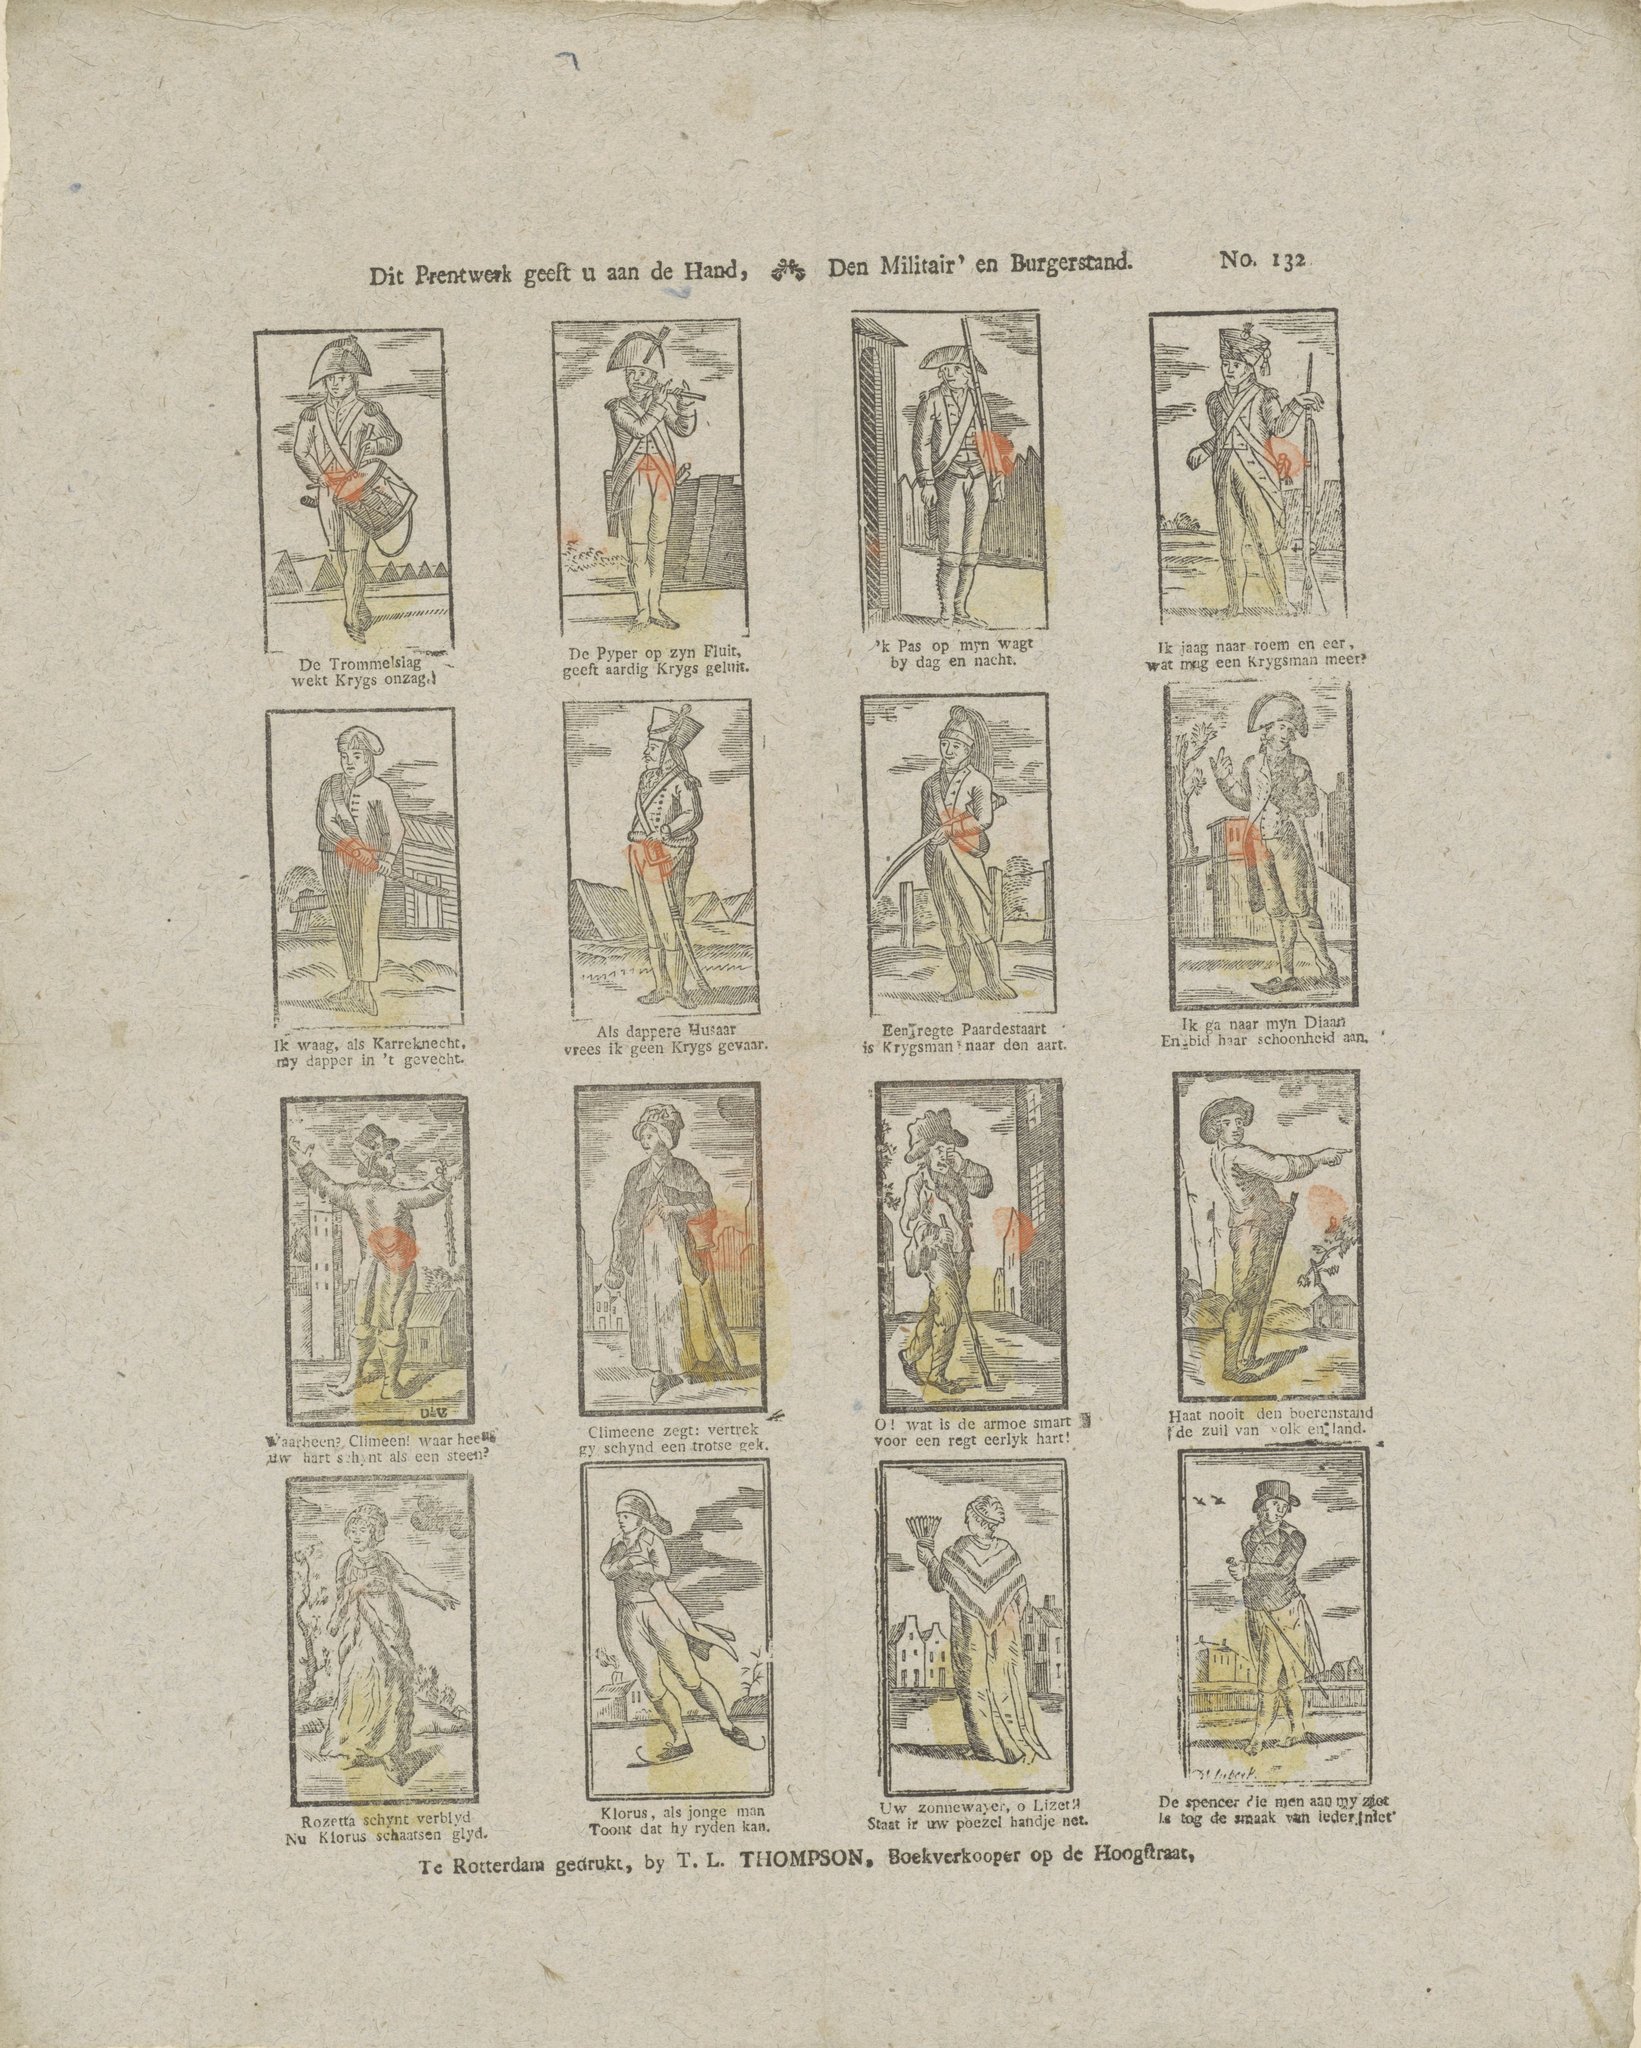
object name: print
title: Dit prentwerk geeft u aan de hand, / Den militair' en burgerstand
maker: t.l. thompson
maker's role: bookseller, publisher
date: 1825-1838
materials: paper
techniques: colour, letterpress printing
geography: rotterdam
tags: military band, characters (human types), the soldier; the soldier's life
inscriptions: collector's mark: Lugt 2760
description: Blad met 16 voorstellingen van militairen en andere figuren. Onder elke afbeelding een tweeregelig vers. Genummerd rechtsboven: No. 132.